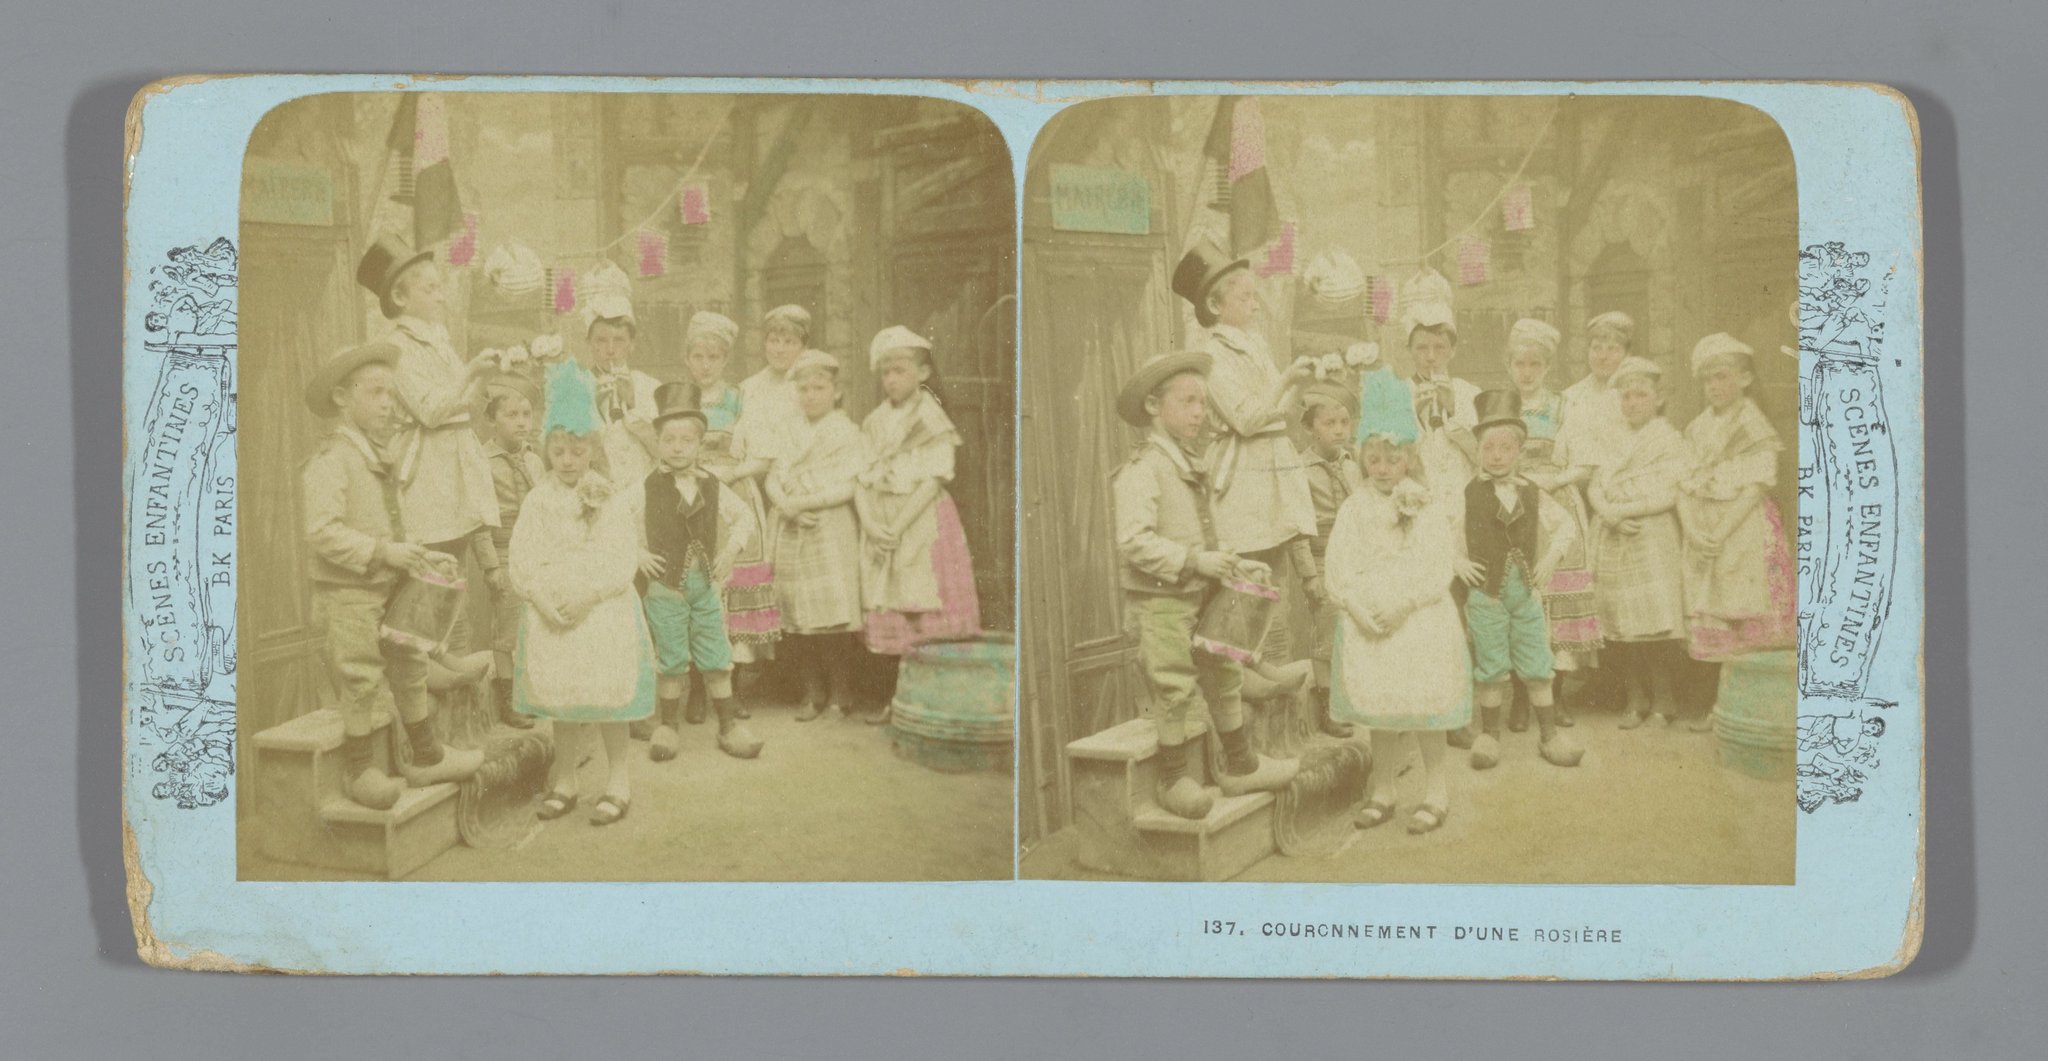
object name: stereograph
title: Tafereel met een rozenmaagd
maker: adolphe block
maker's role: publisher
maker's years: 1829-1918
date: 1868-1890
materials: cardboard, paper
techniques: albumen print, hand coloring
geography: paris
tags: child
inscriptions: number: ‘137’, inscription: ‘Rn 142’